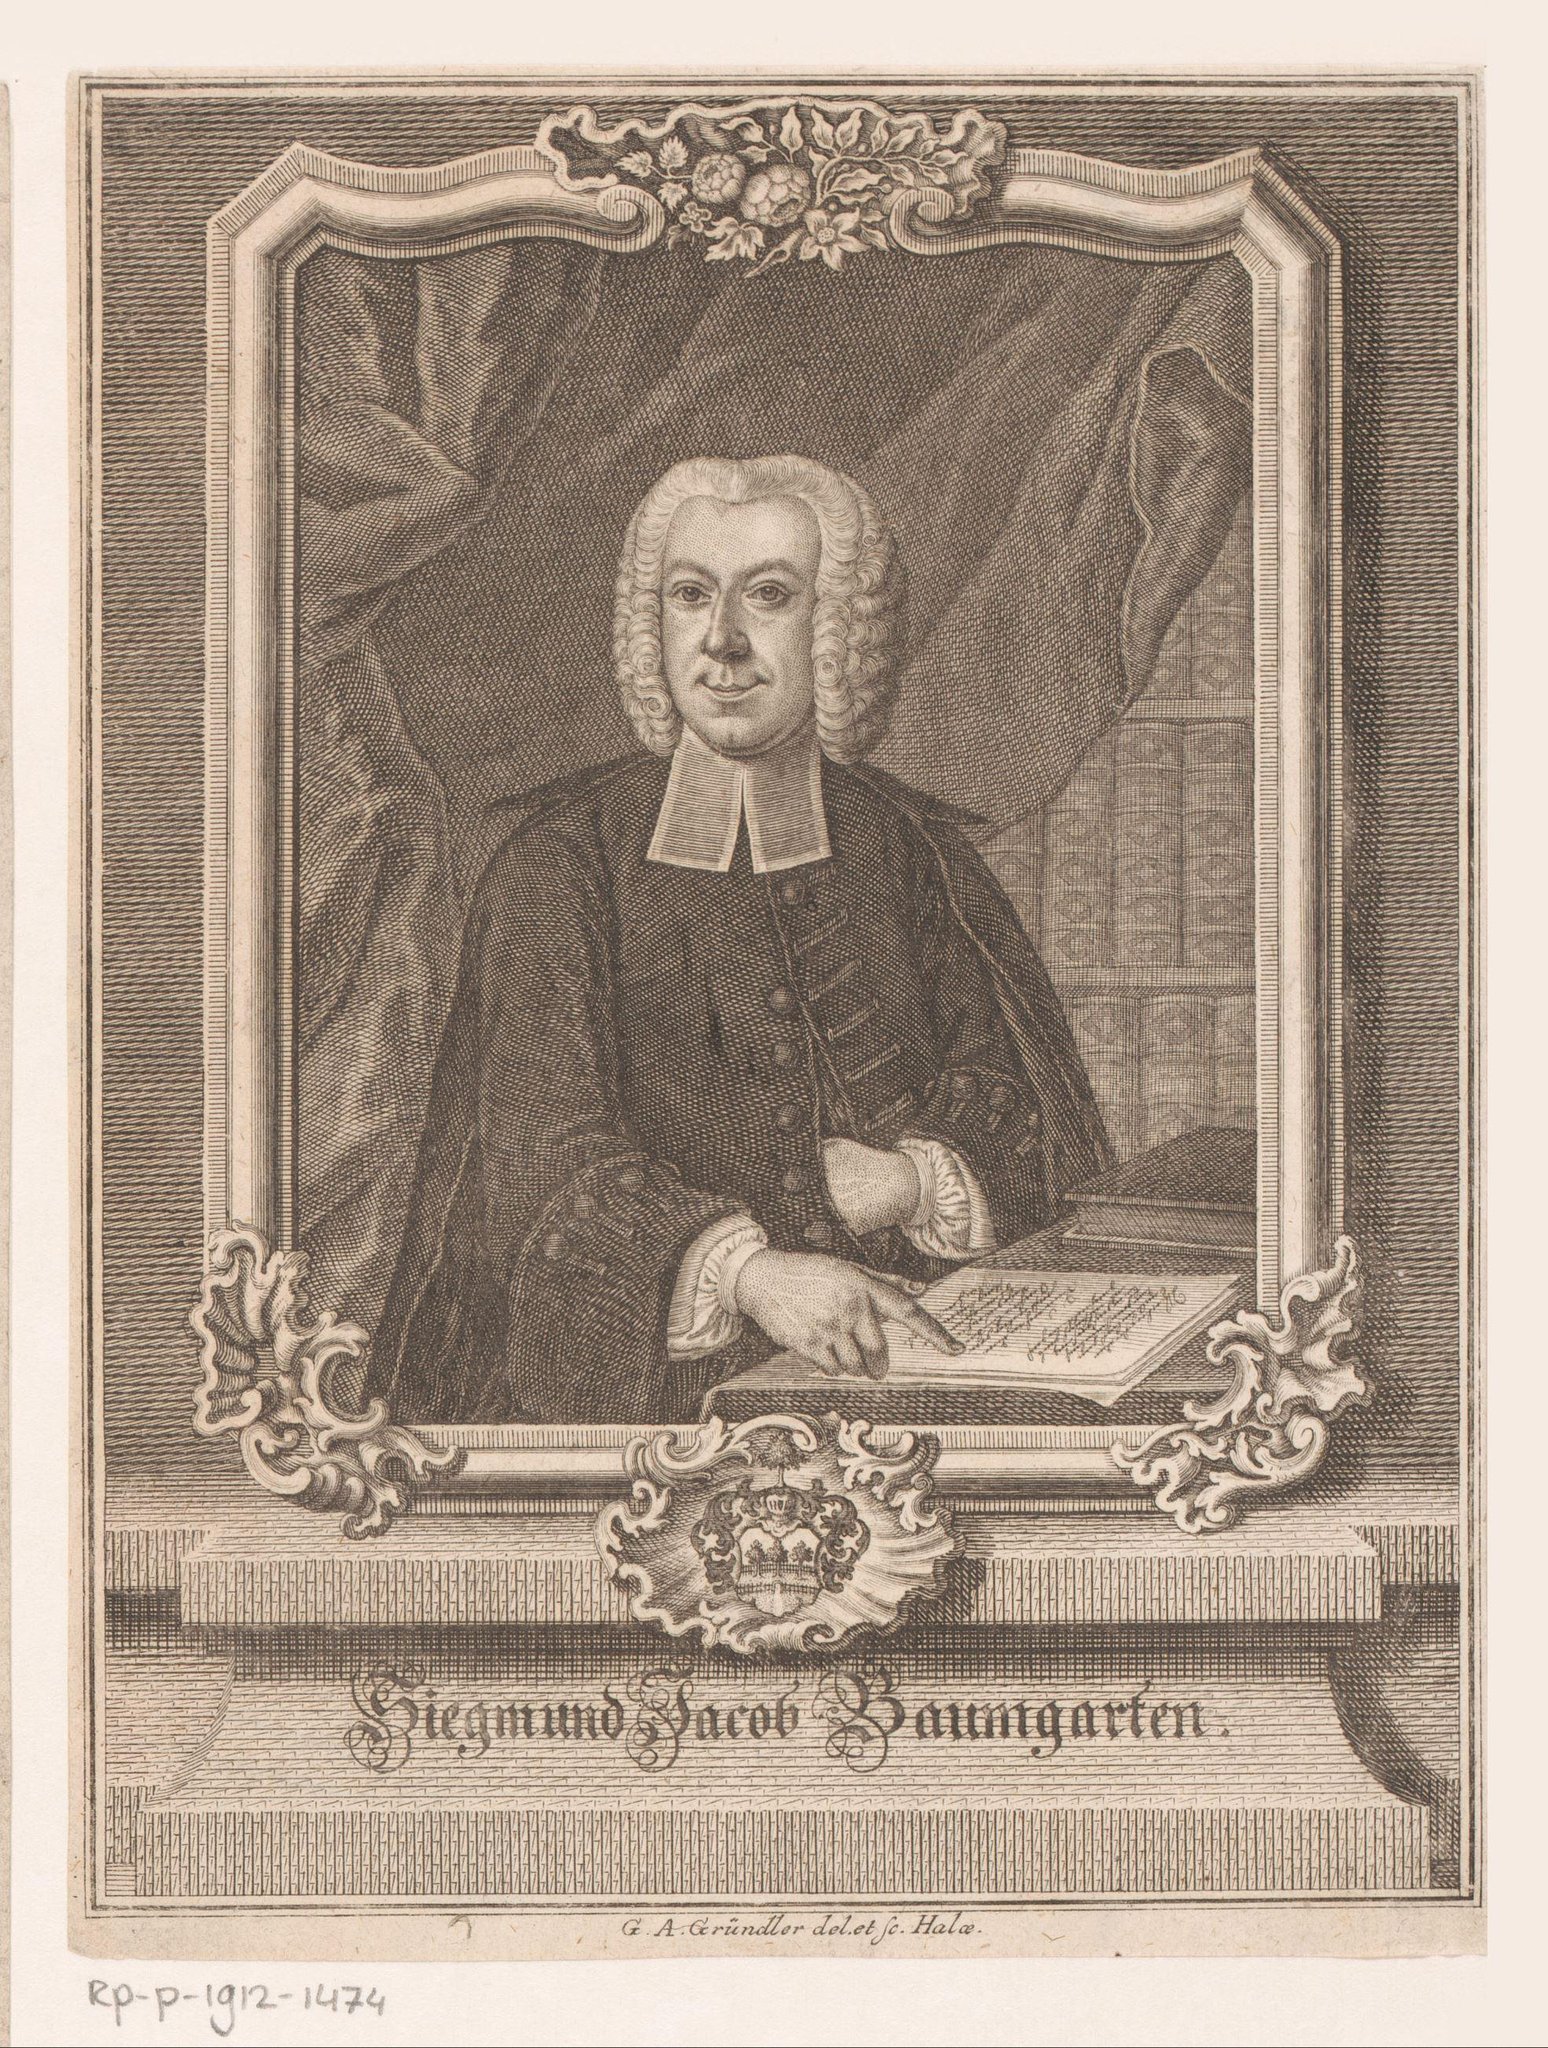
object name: print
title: Portret van Sigmund Jacob Baumgarten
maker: gottfried august gründler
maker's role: painter, print maker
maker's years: 1710-1775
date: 1759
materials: paper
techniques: engraving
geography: halle an der saale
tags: bookshelves, rocaille ornament, theologian, historical persons, armorial bearing, heraldry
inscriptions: collector's mark: Lugt 2228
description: Prent gebruikt voor: Baumgarten, Sigmund Jacob. Evangelische Glaubenslehre. Halle an der Saale: Johann Justinus Gebauer, 1759.